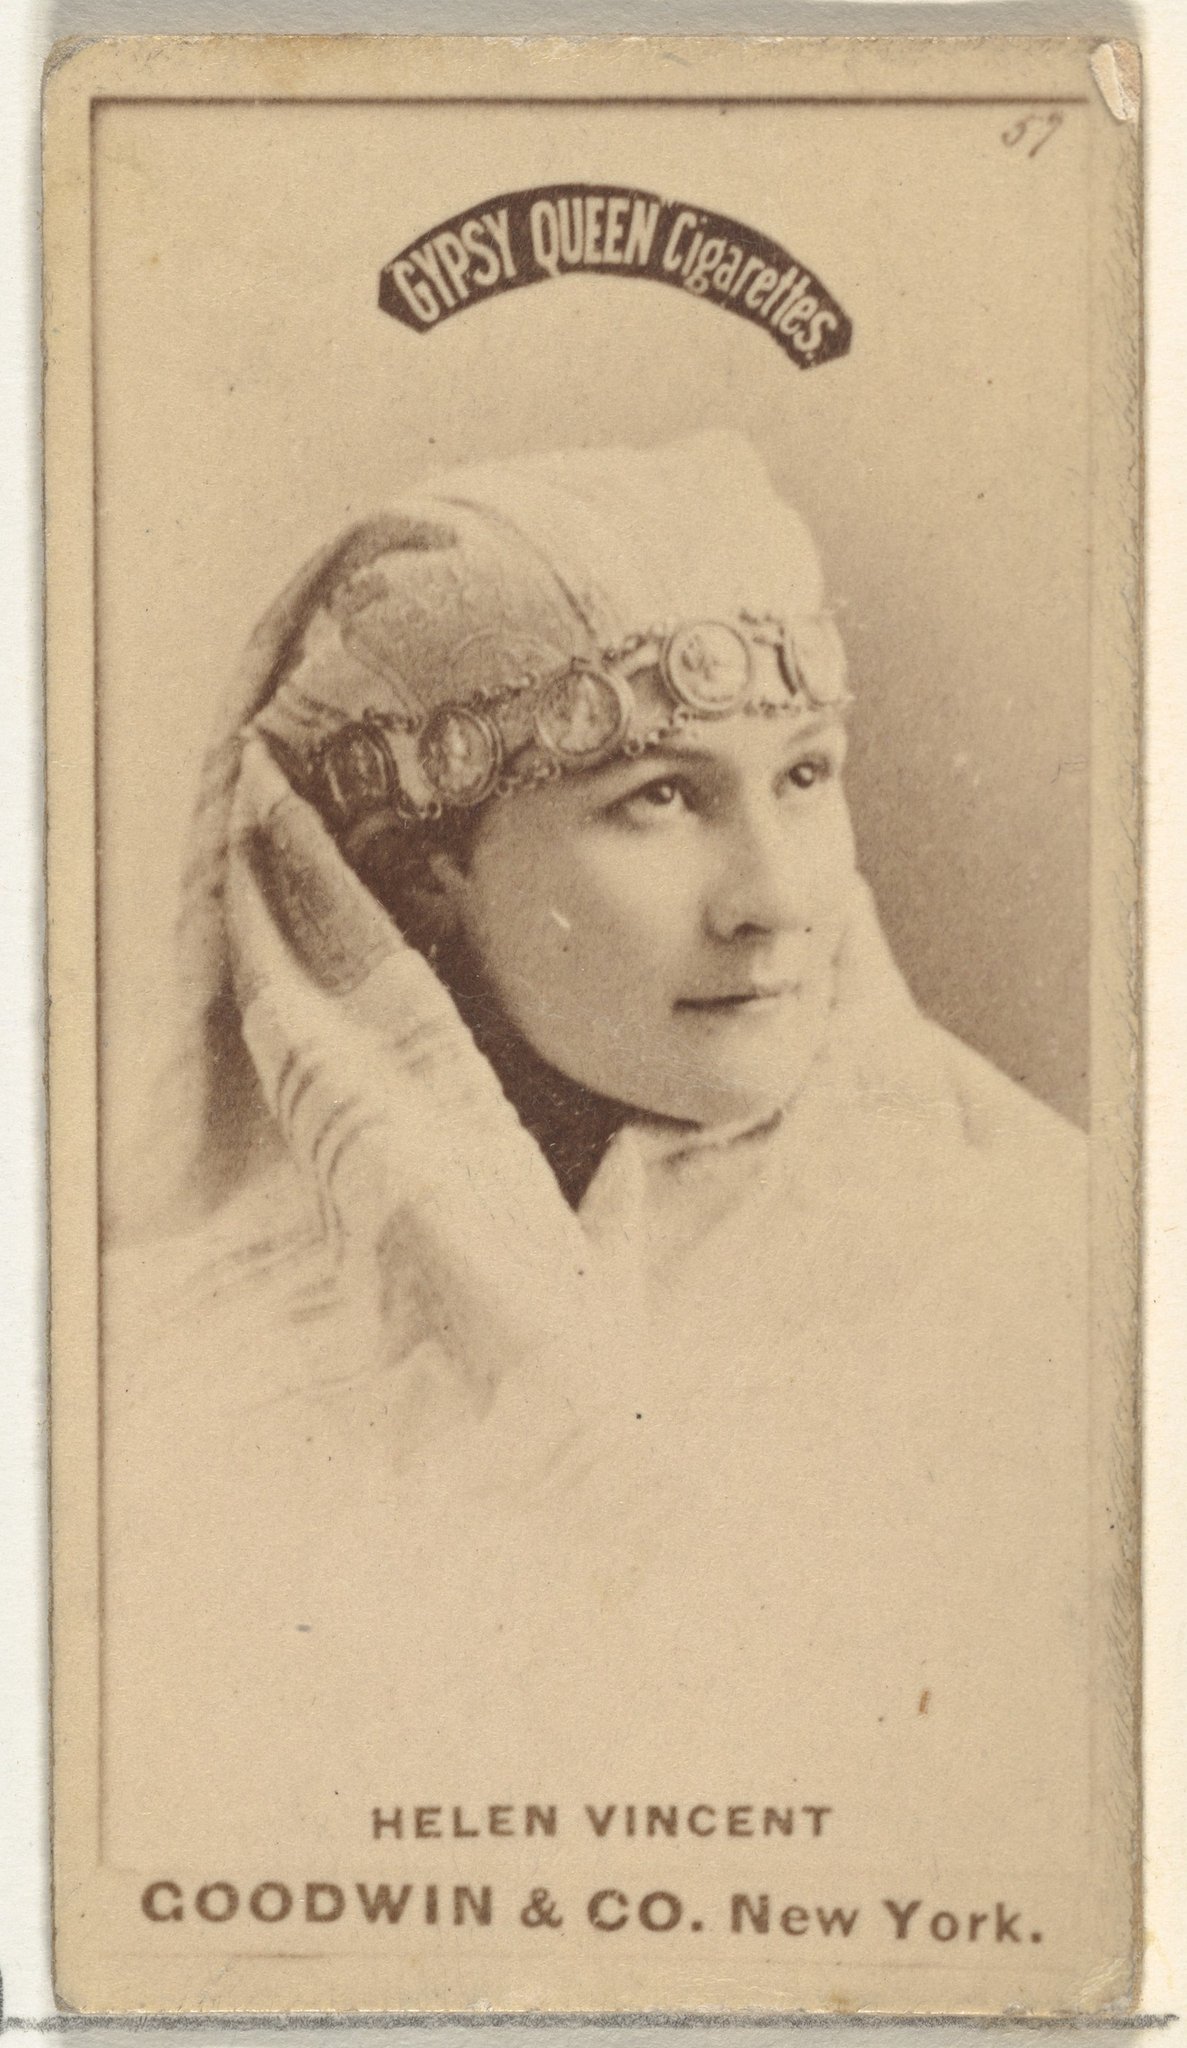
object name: photograph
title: Helen Vincent, from the Actors and Actresses series (N171) for Gypsy Queen Cigarettes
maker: goodwin & company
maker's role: publisher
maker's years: 1850-1950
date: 1886-1890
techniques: albumen silver print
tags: portraits,women,actresses